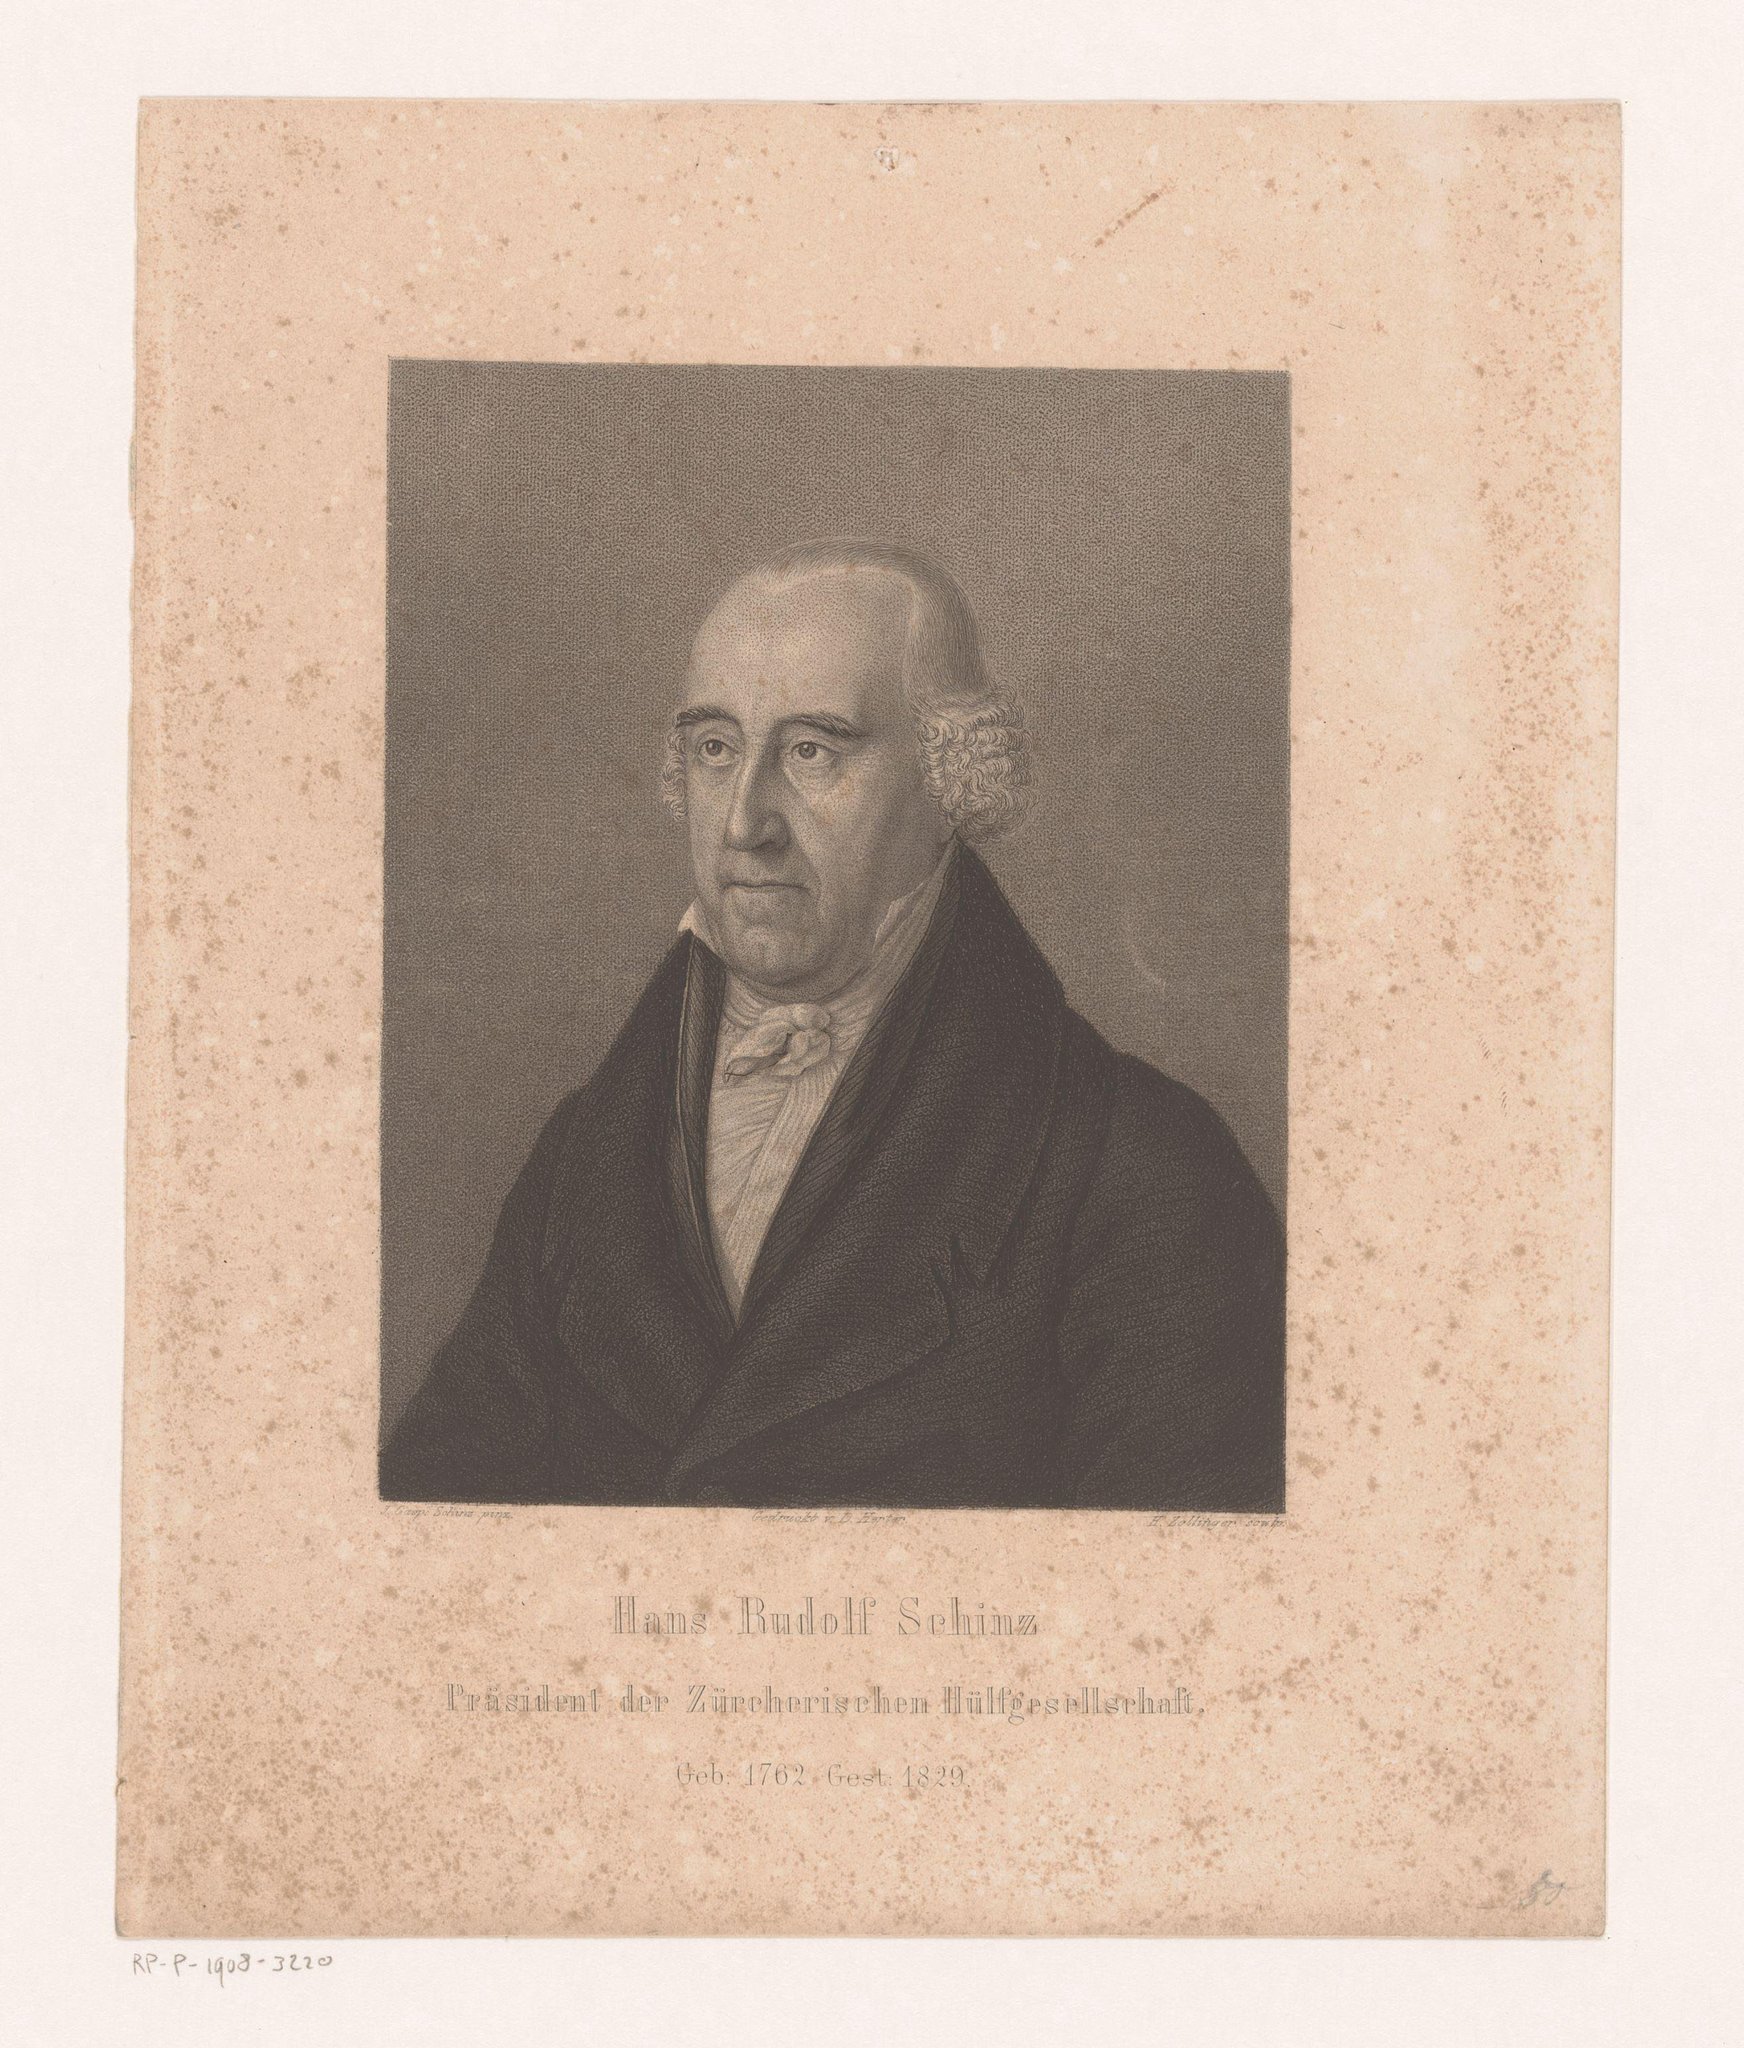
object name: print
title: Portret van Hans Rudolf Schinz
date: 1831-1891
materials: paper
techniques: aquatint, etching, roulette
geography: germany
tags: historical persons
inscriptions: collector's mark: Lugt 2228